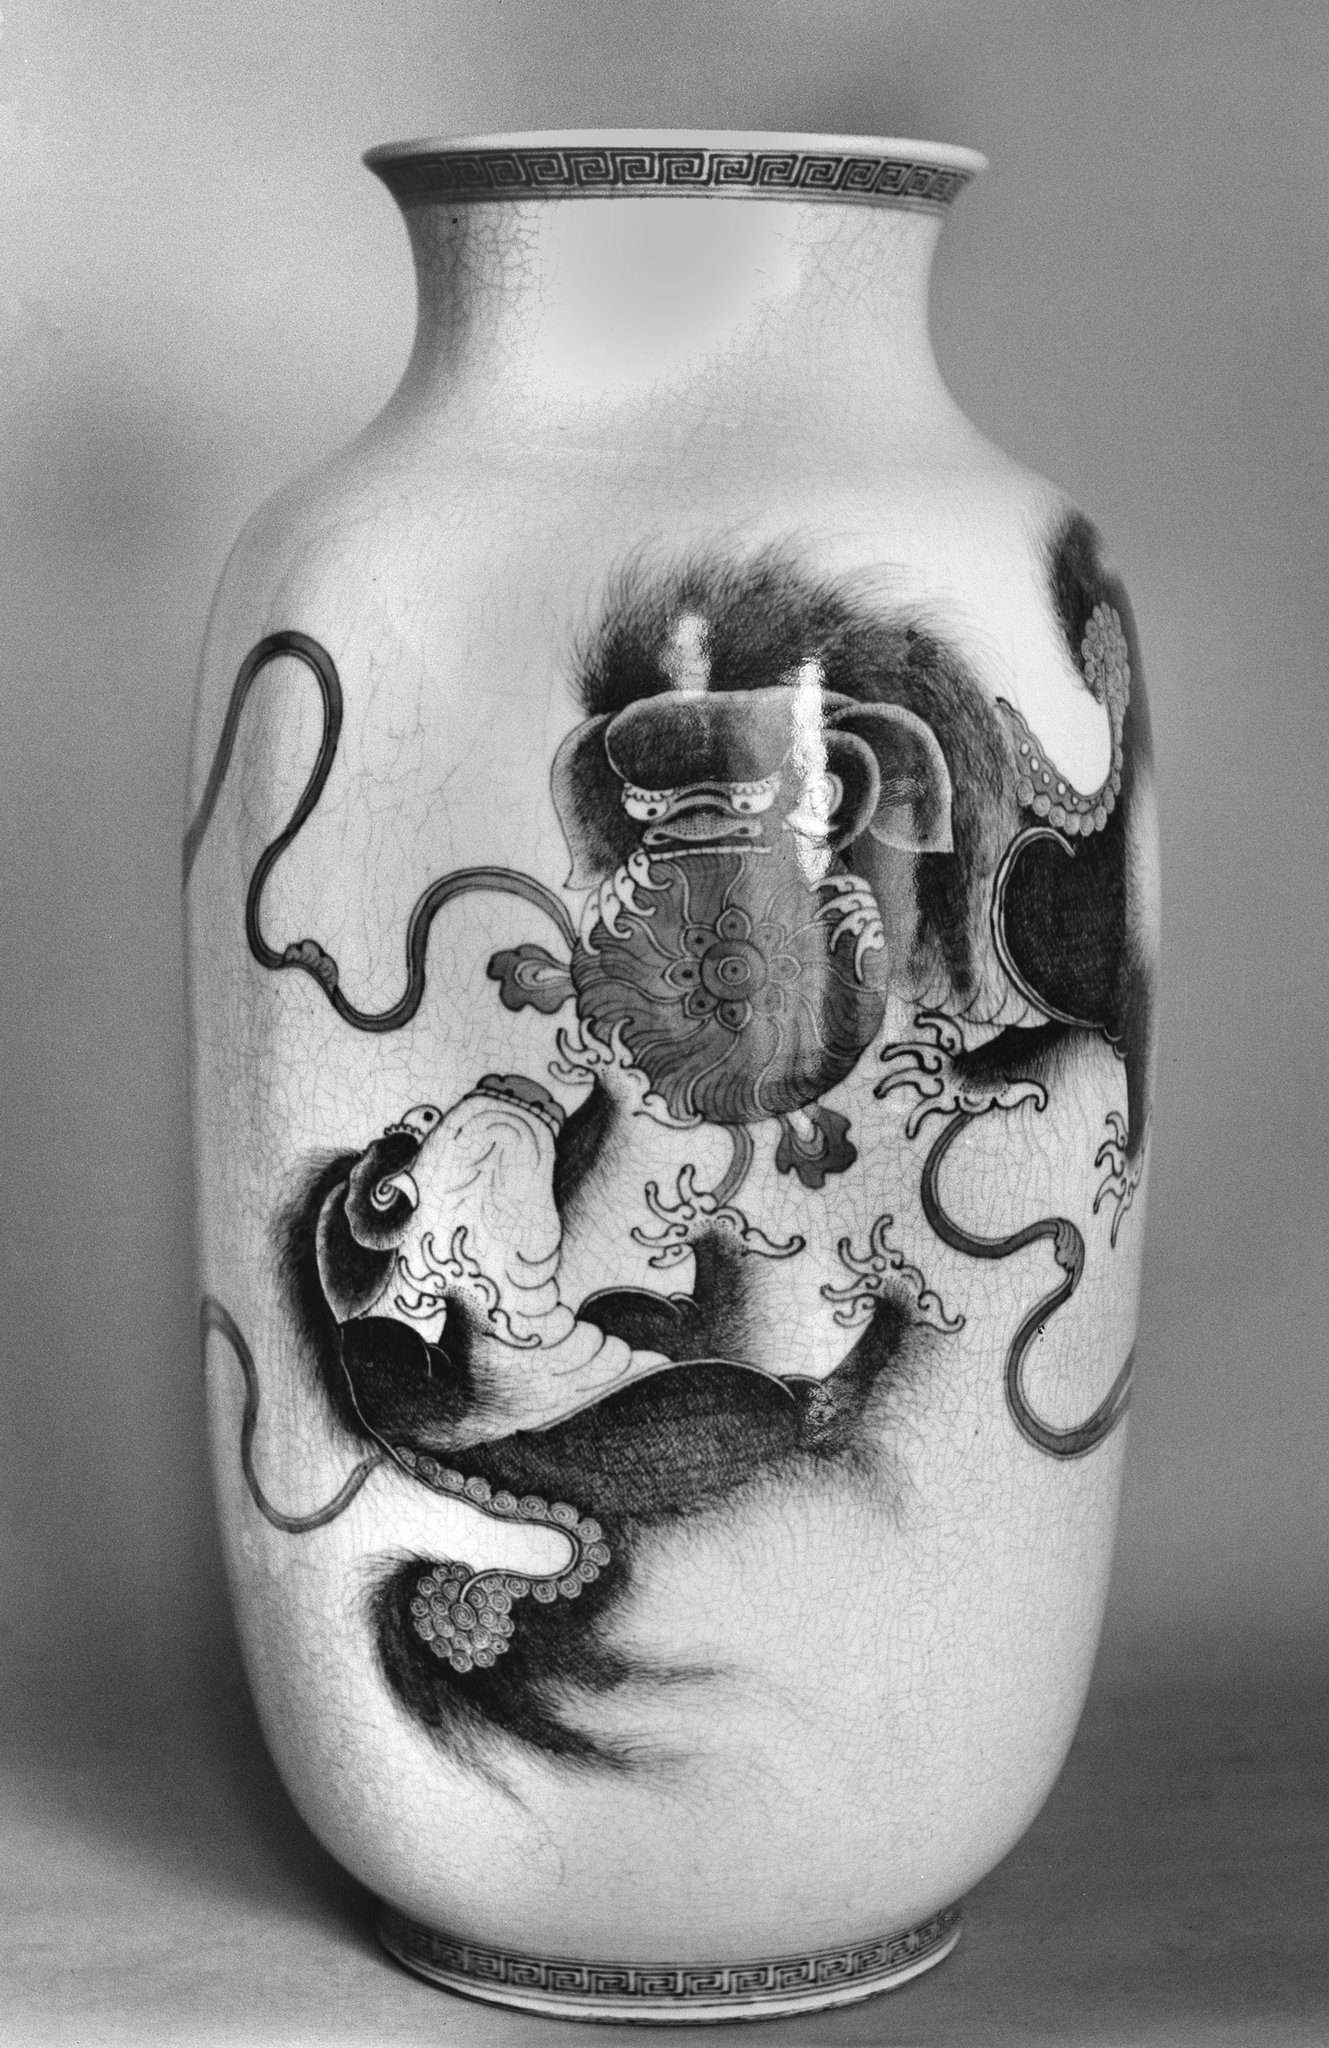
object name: vase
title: Vase with lions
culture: chinese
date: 1734-1766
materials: cobalt, porcelain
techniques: painting, underglaze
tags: lions